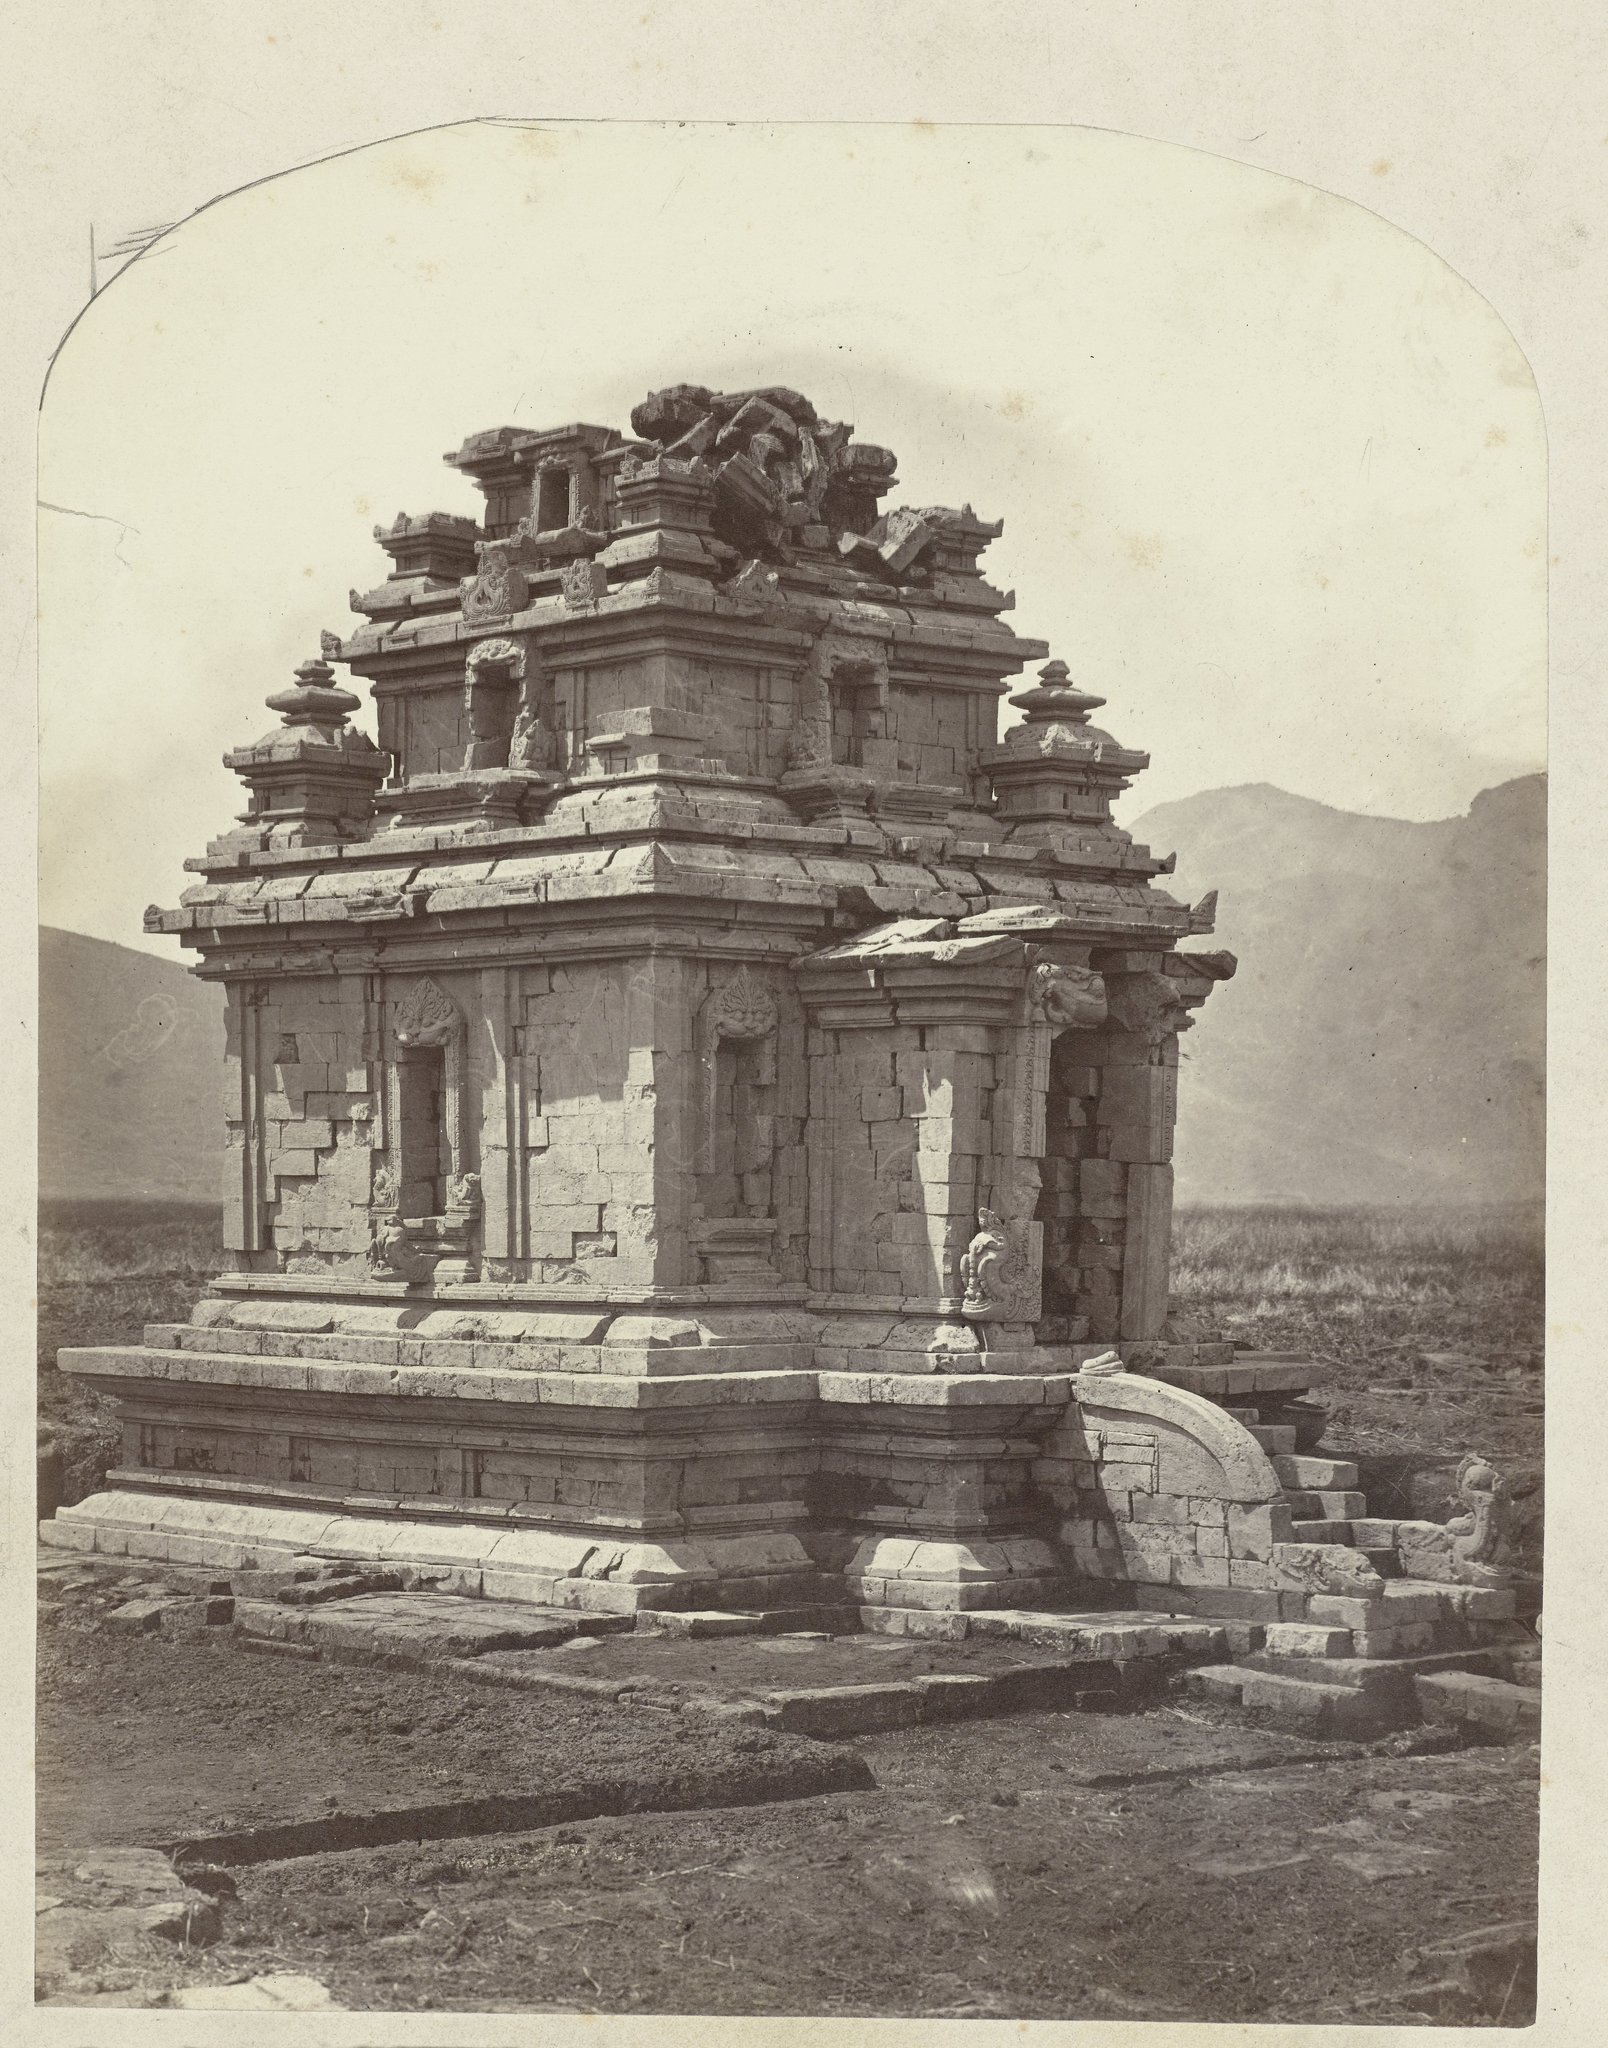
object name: photograph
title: Candi Arjuna, general view showing the staicase projection and the entrance (west). Dieng plateau, Wonosobo district, Central Java province, 8th-9th century.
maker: isidore kinsbergen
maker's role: fotograaf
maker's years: 1821-1905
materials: cardboard, paper, photographic support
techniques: albumen print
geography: java